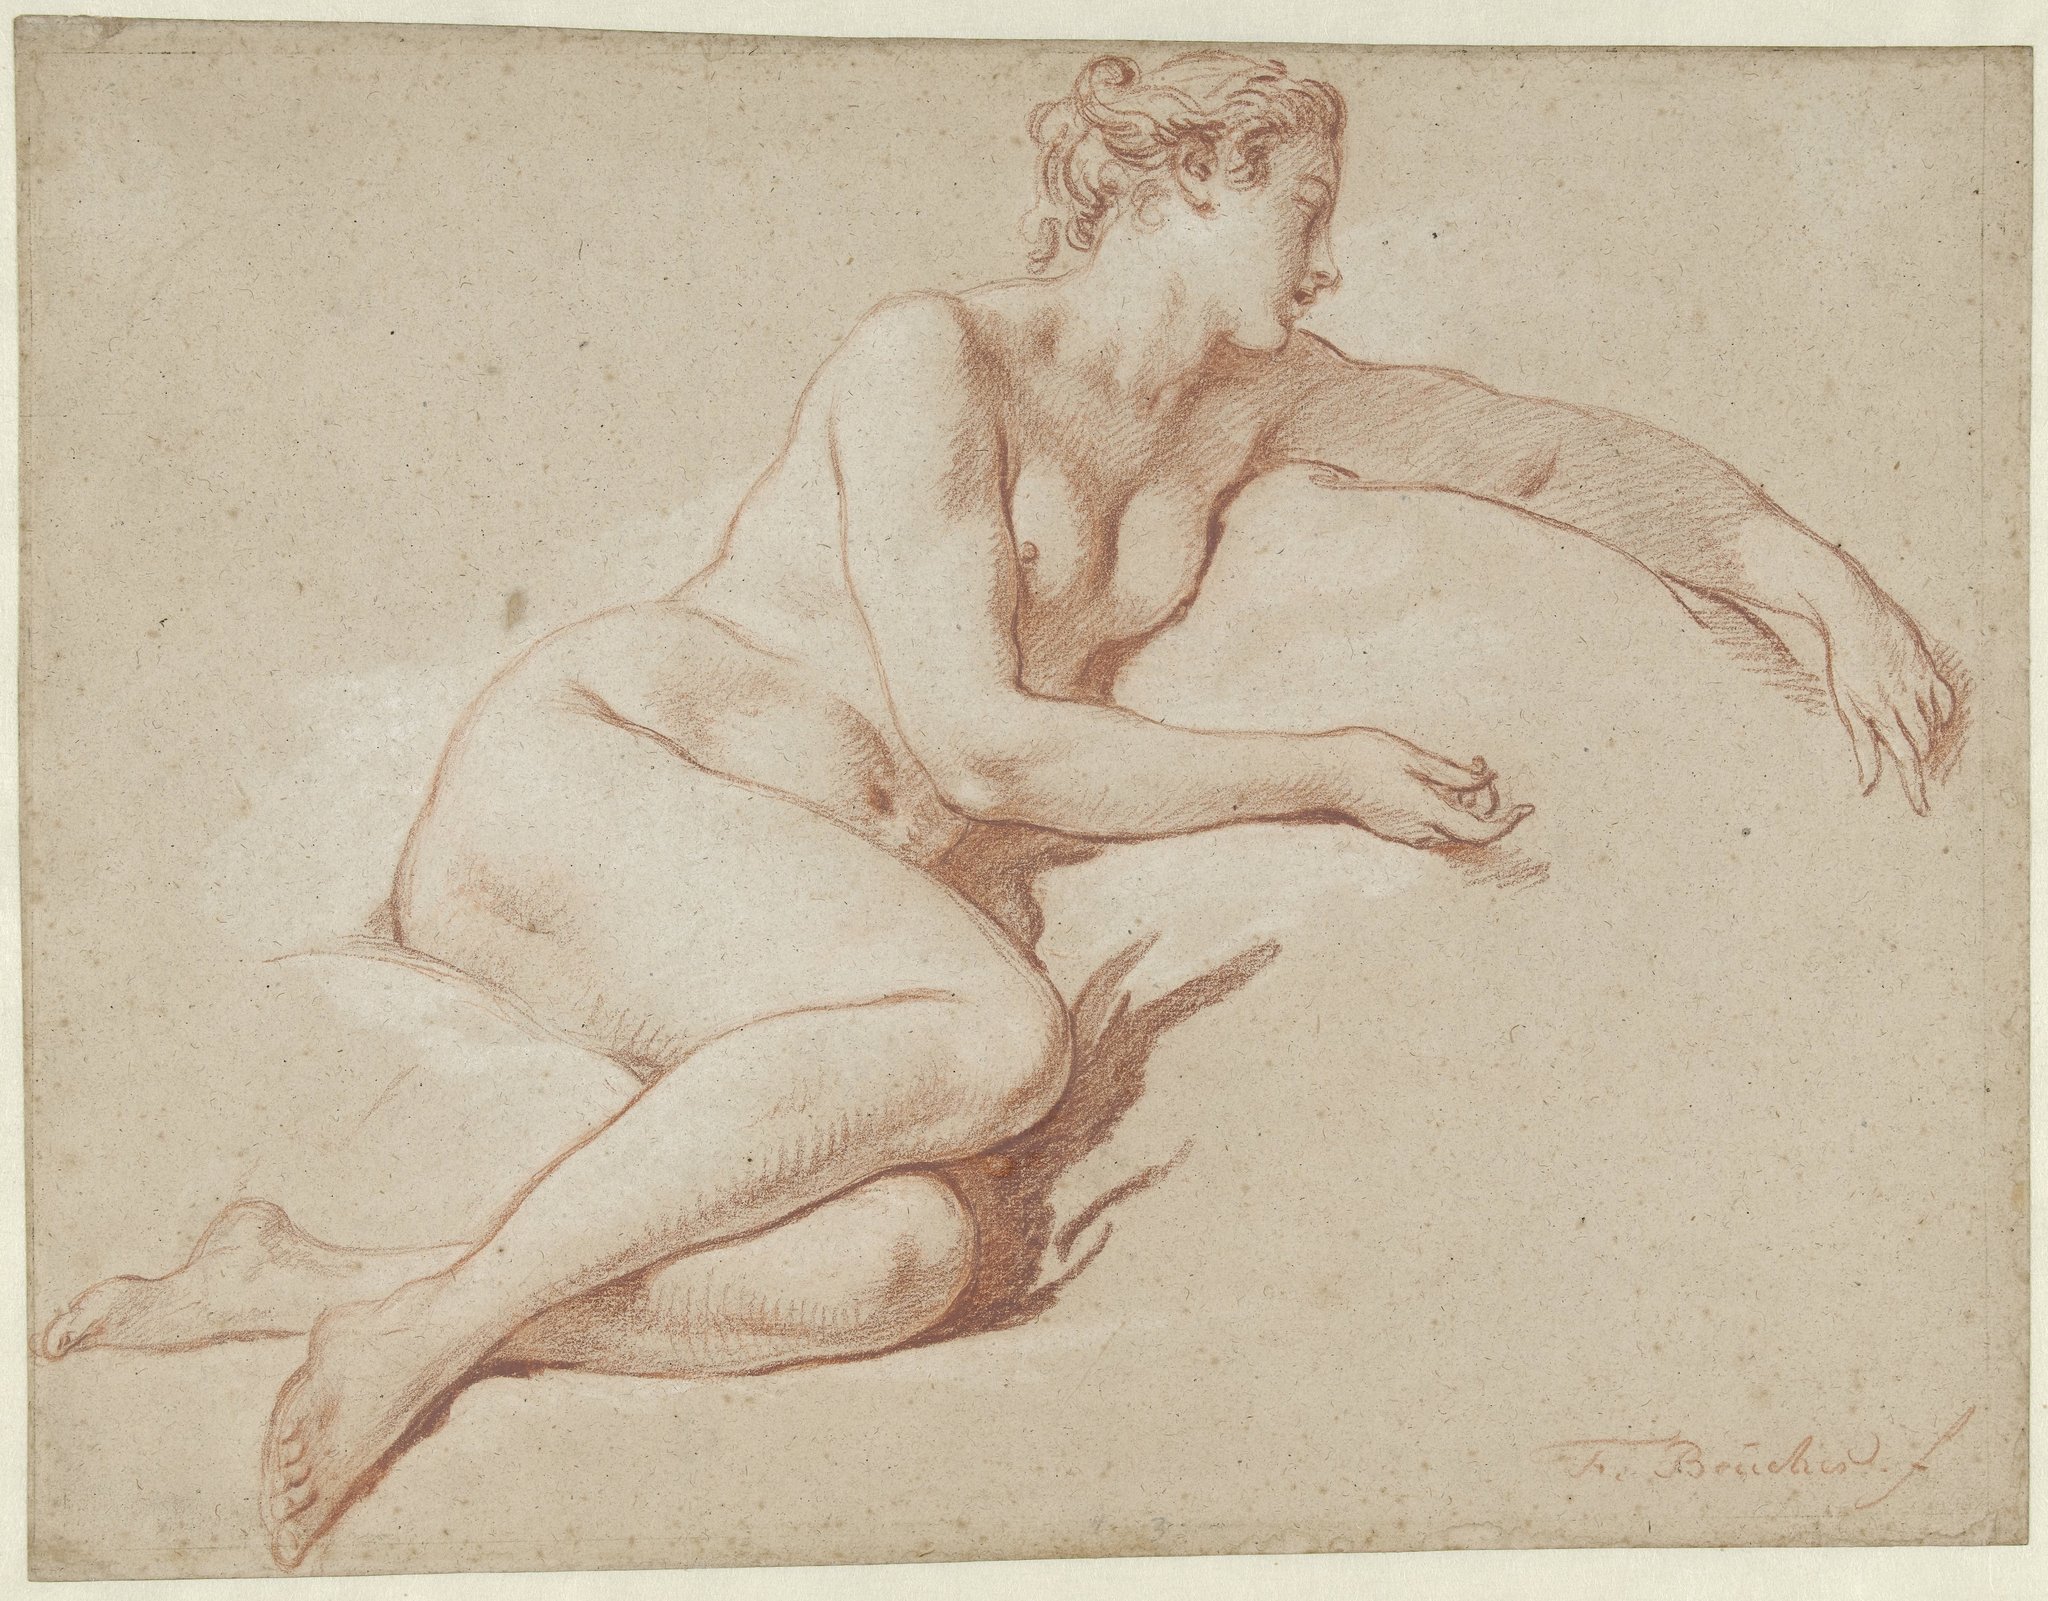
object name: drawing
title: Reclining Female Nude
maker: françois boucher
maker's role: draughtsman, print maker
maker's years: 1703-1770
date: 1750-1760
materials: chalk, paper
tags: lying figure - aa - female human figure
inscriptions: annotation, recto, lower right, red chalk: ‘F. Boucher. f’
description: Boucher drew this beautiful female nude to use in a painting. That canvas is no longer known. However, there is a frivolous print with this nude under the misleading title ‘Mademoiselle de *** en habit d’Eté’ (Miss Van *** in summer clothes). In it, she is shown reclining on a drapery at the edge of a pool bordered by plants.